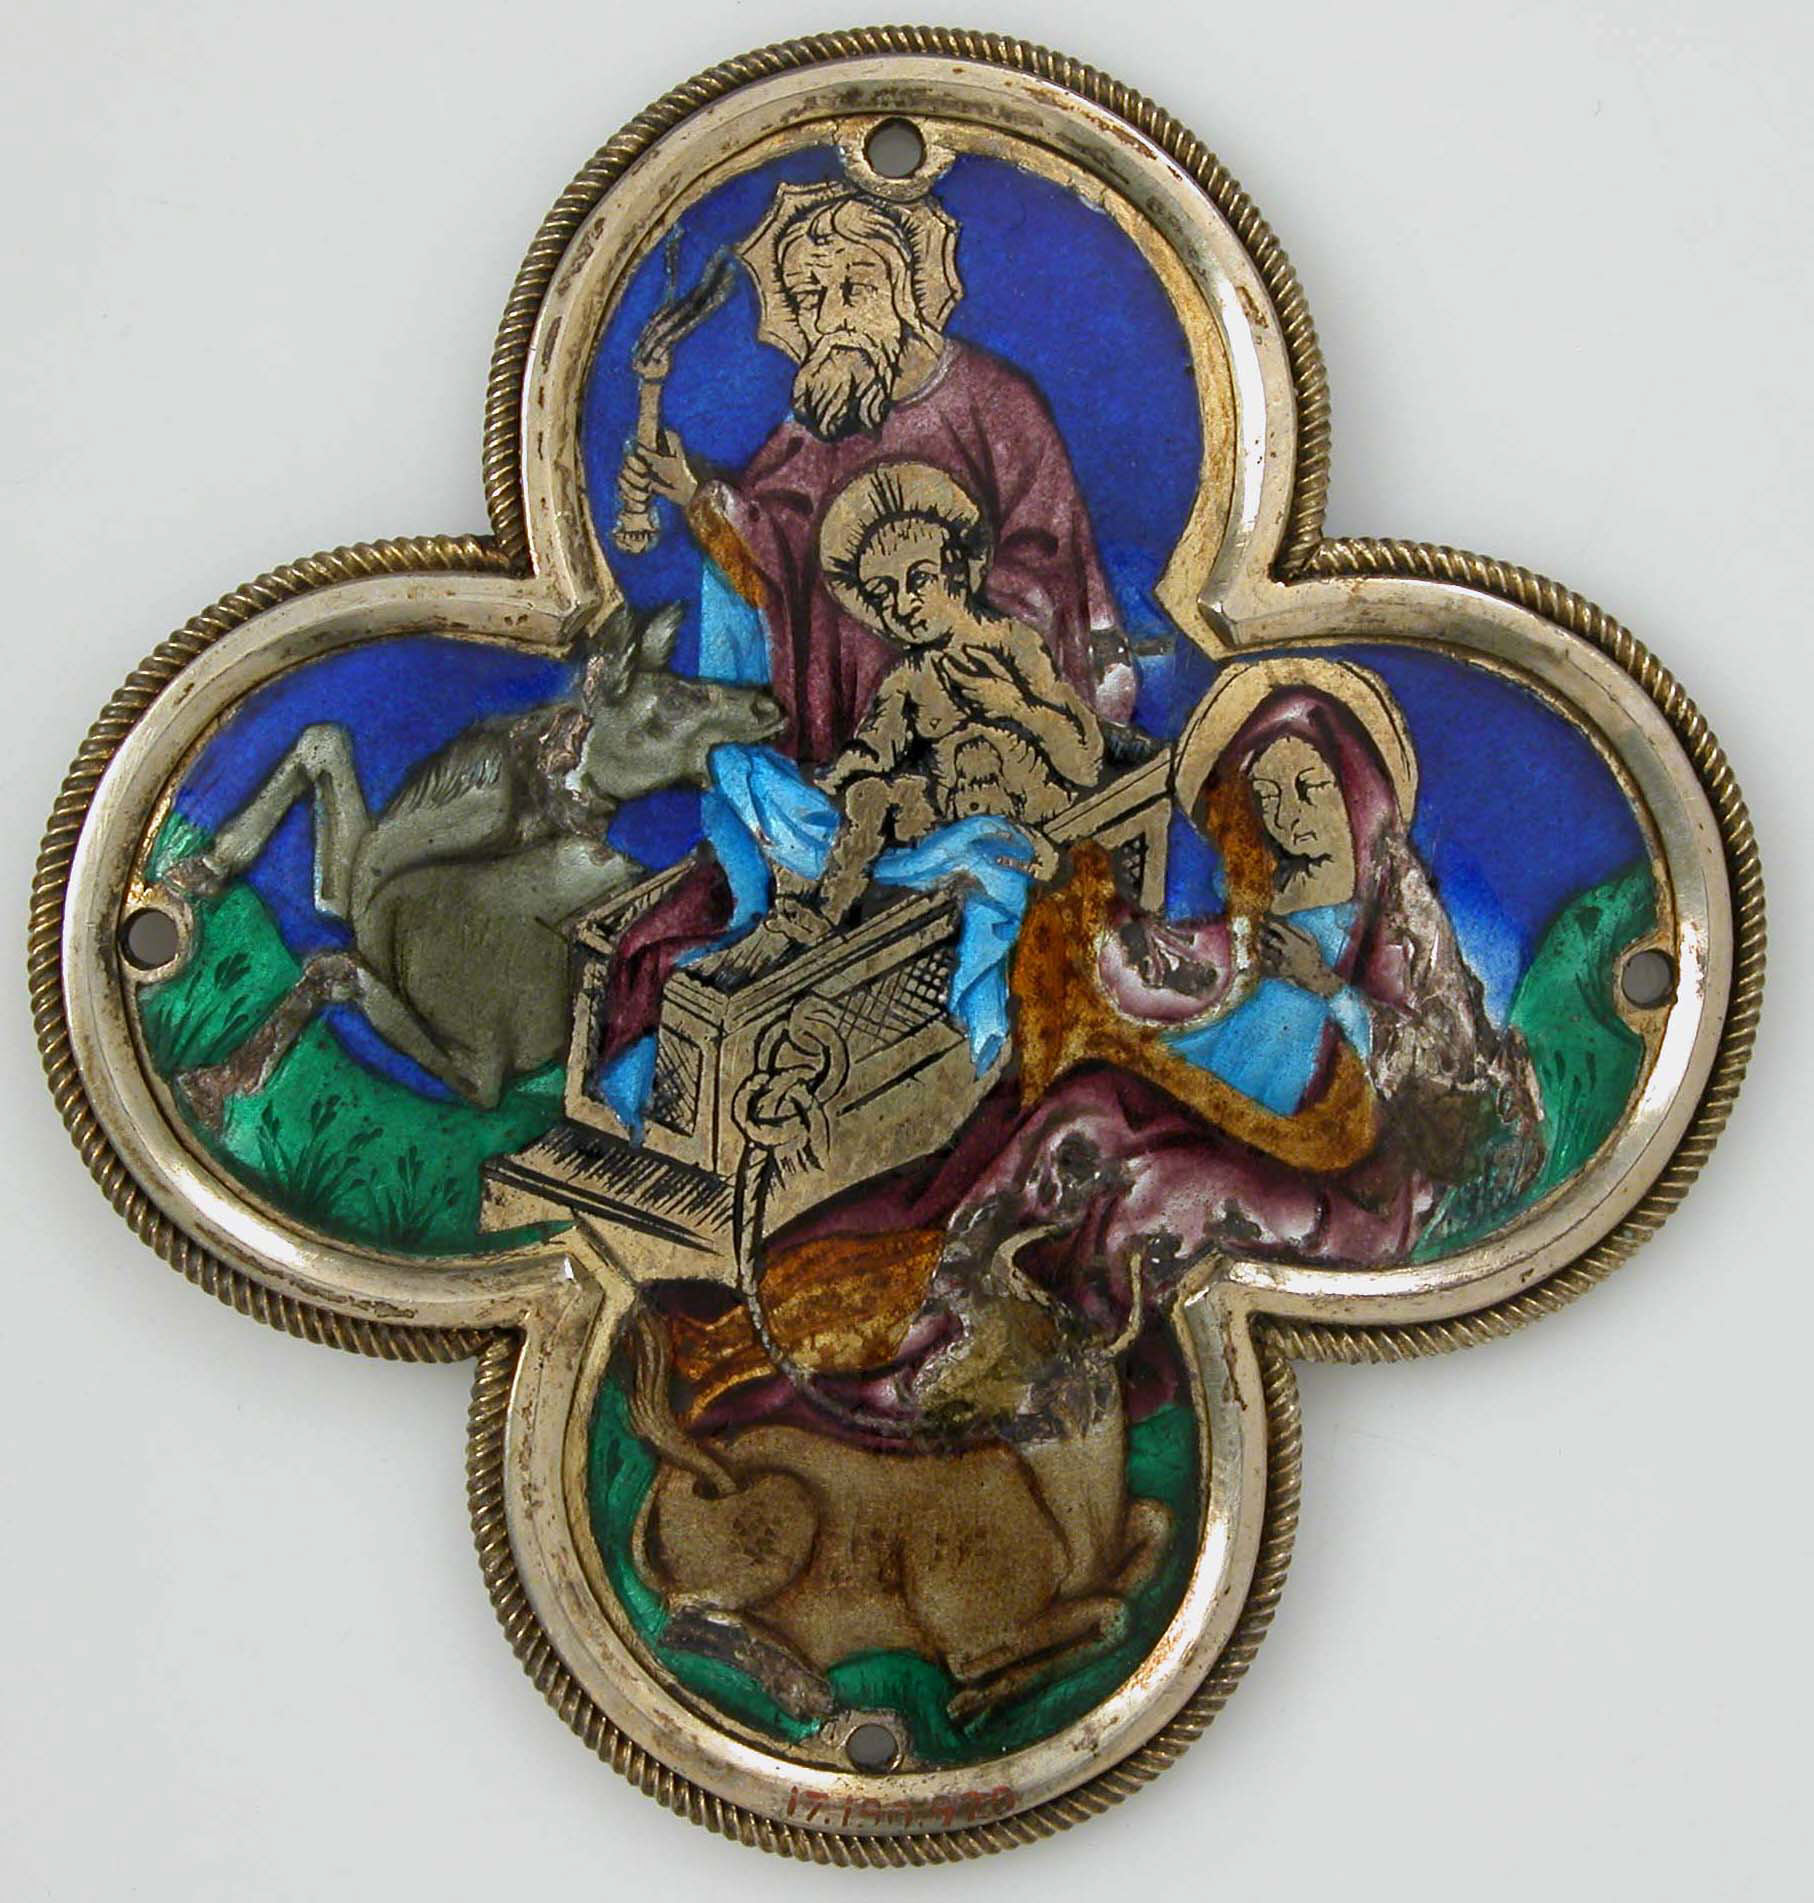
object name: plaque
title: Quatrefoil Plaque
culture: south netherlandish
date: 1401-1500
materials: enamel, silver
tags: donkeys,holy family,jesus,nativity,ox